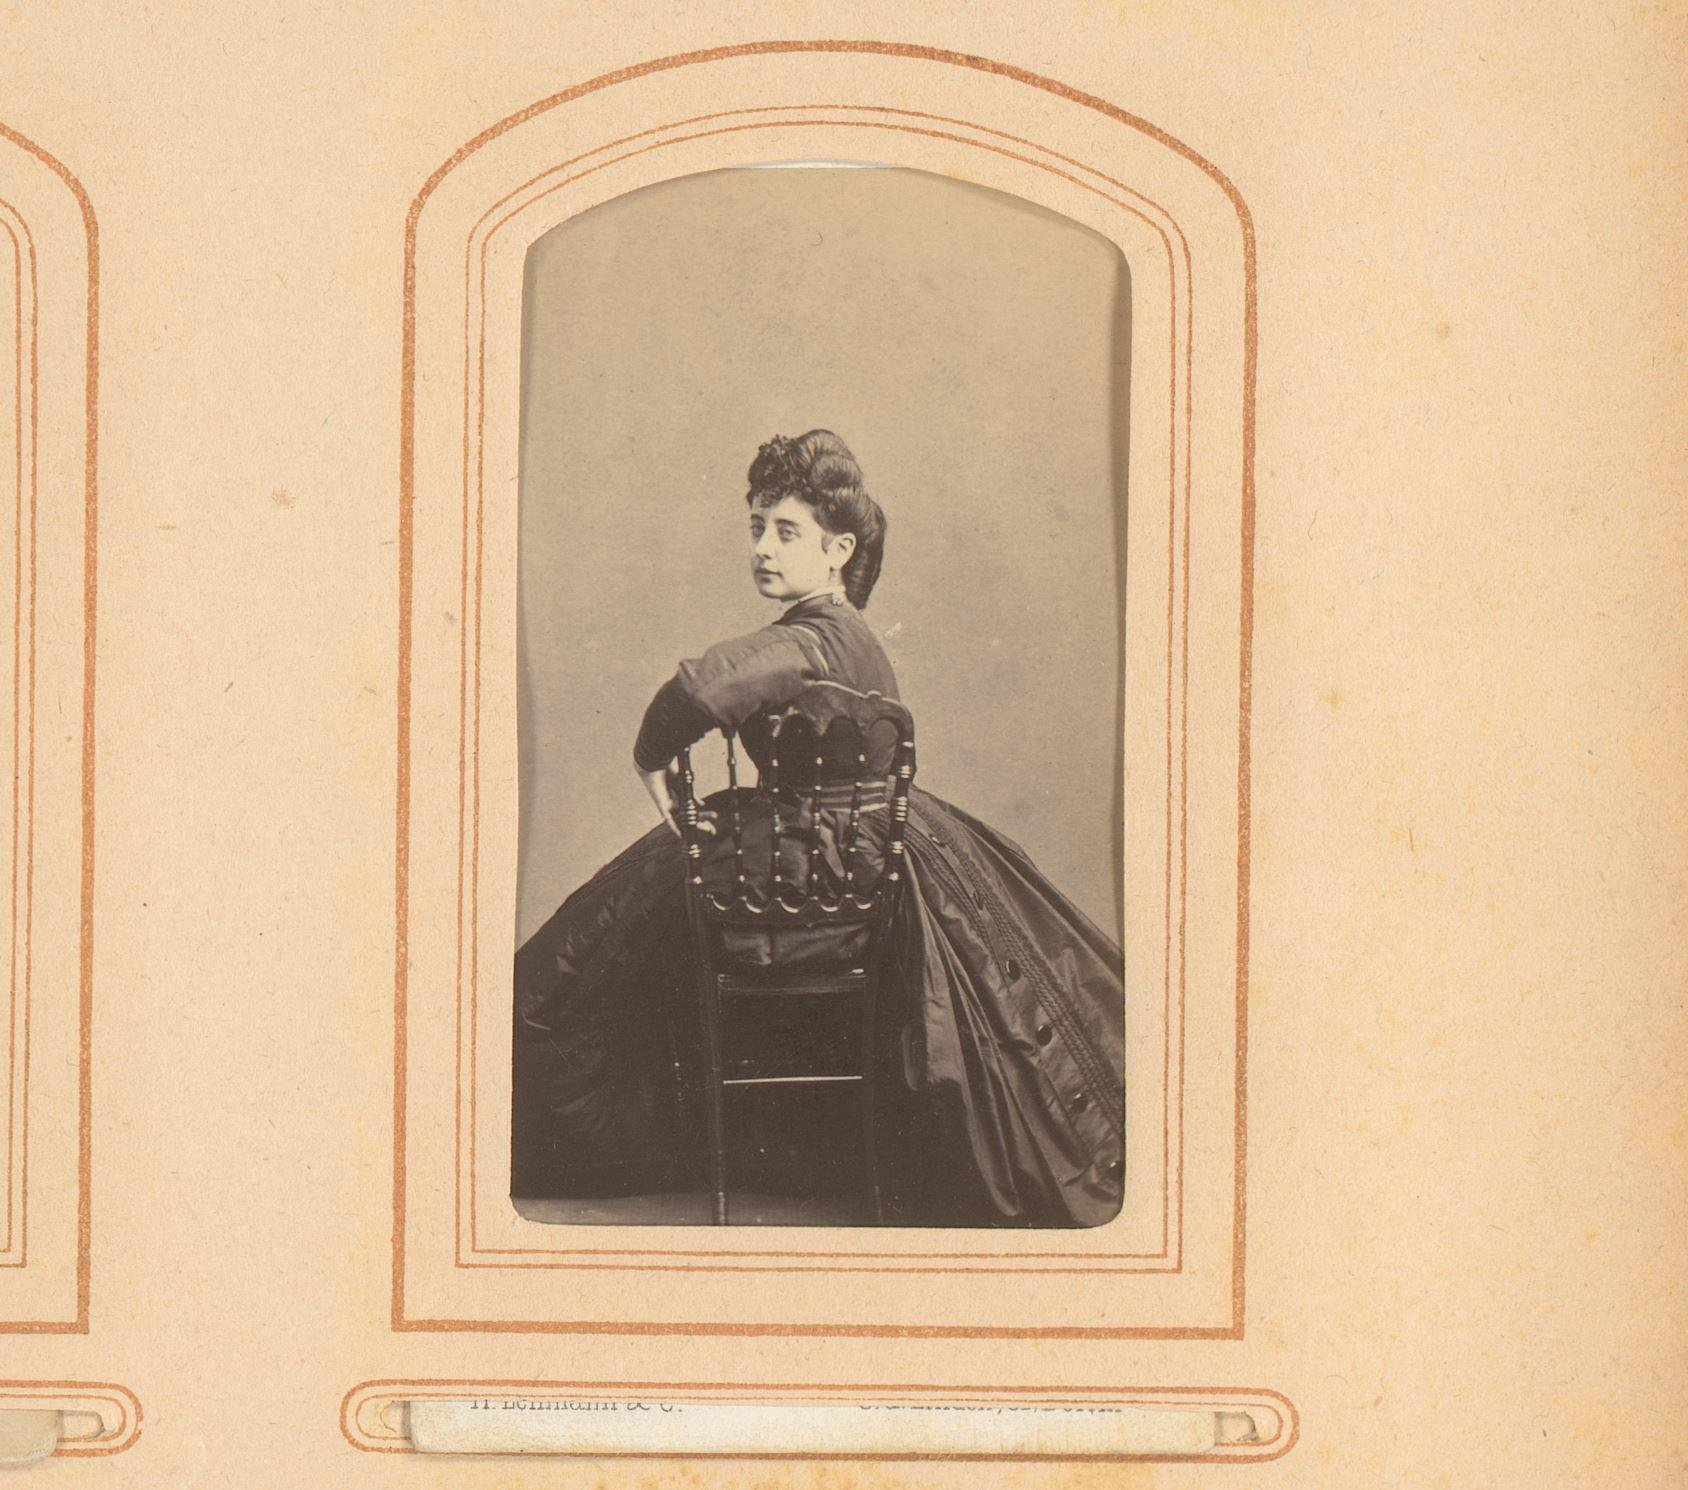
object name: carte de visite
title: Portret van Pauline Lucca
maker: hugo lehmann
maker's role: fotograaf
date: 1855-1890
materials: cardboard, photographic support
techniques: albumen print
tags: adult woman, historical persons, portrait of opera-singer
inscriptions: inscription: ‘H. Lehmann & Co./ Berlin/ Unter den Linden No. 51/ 2 Treppen’, annotation: ‘Pauline Lucca/ 1841-1908’